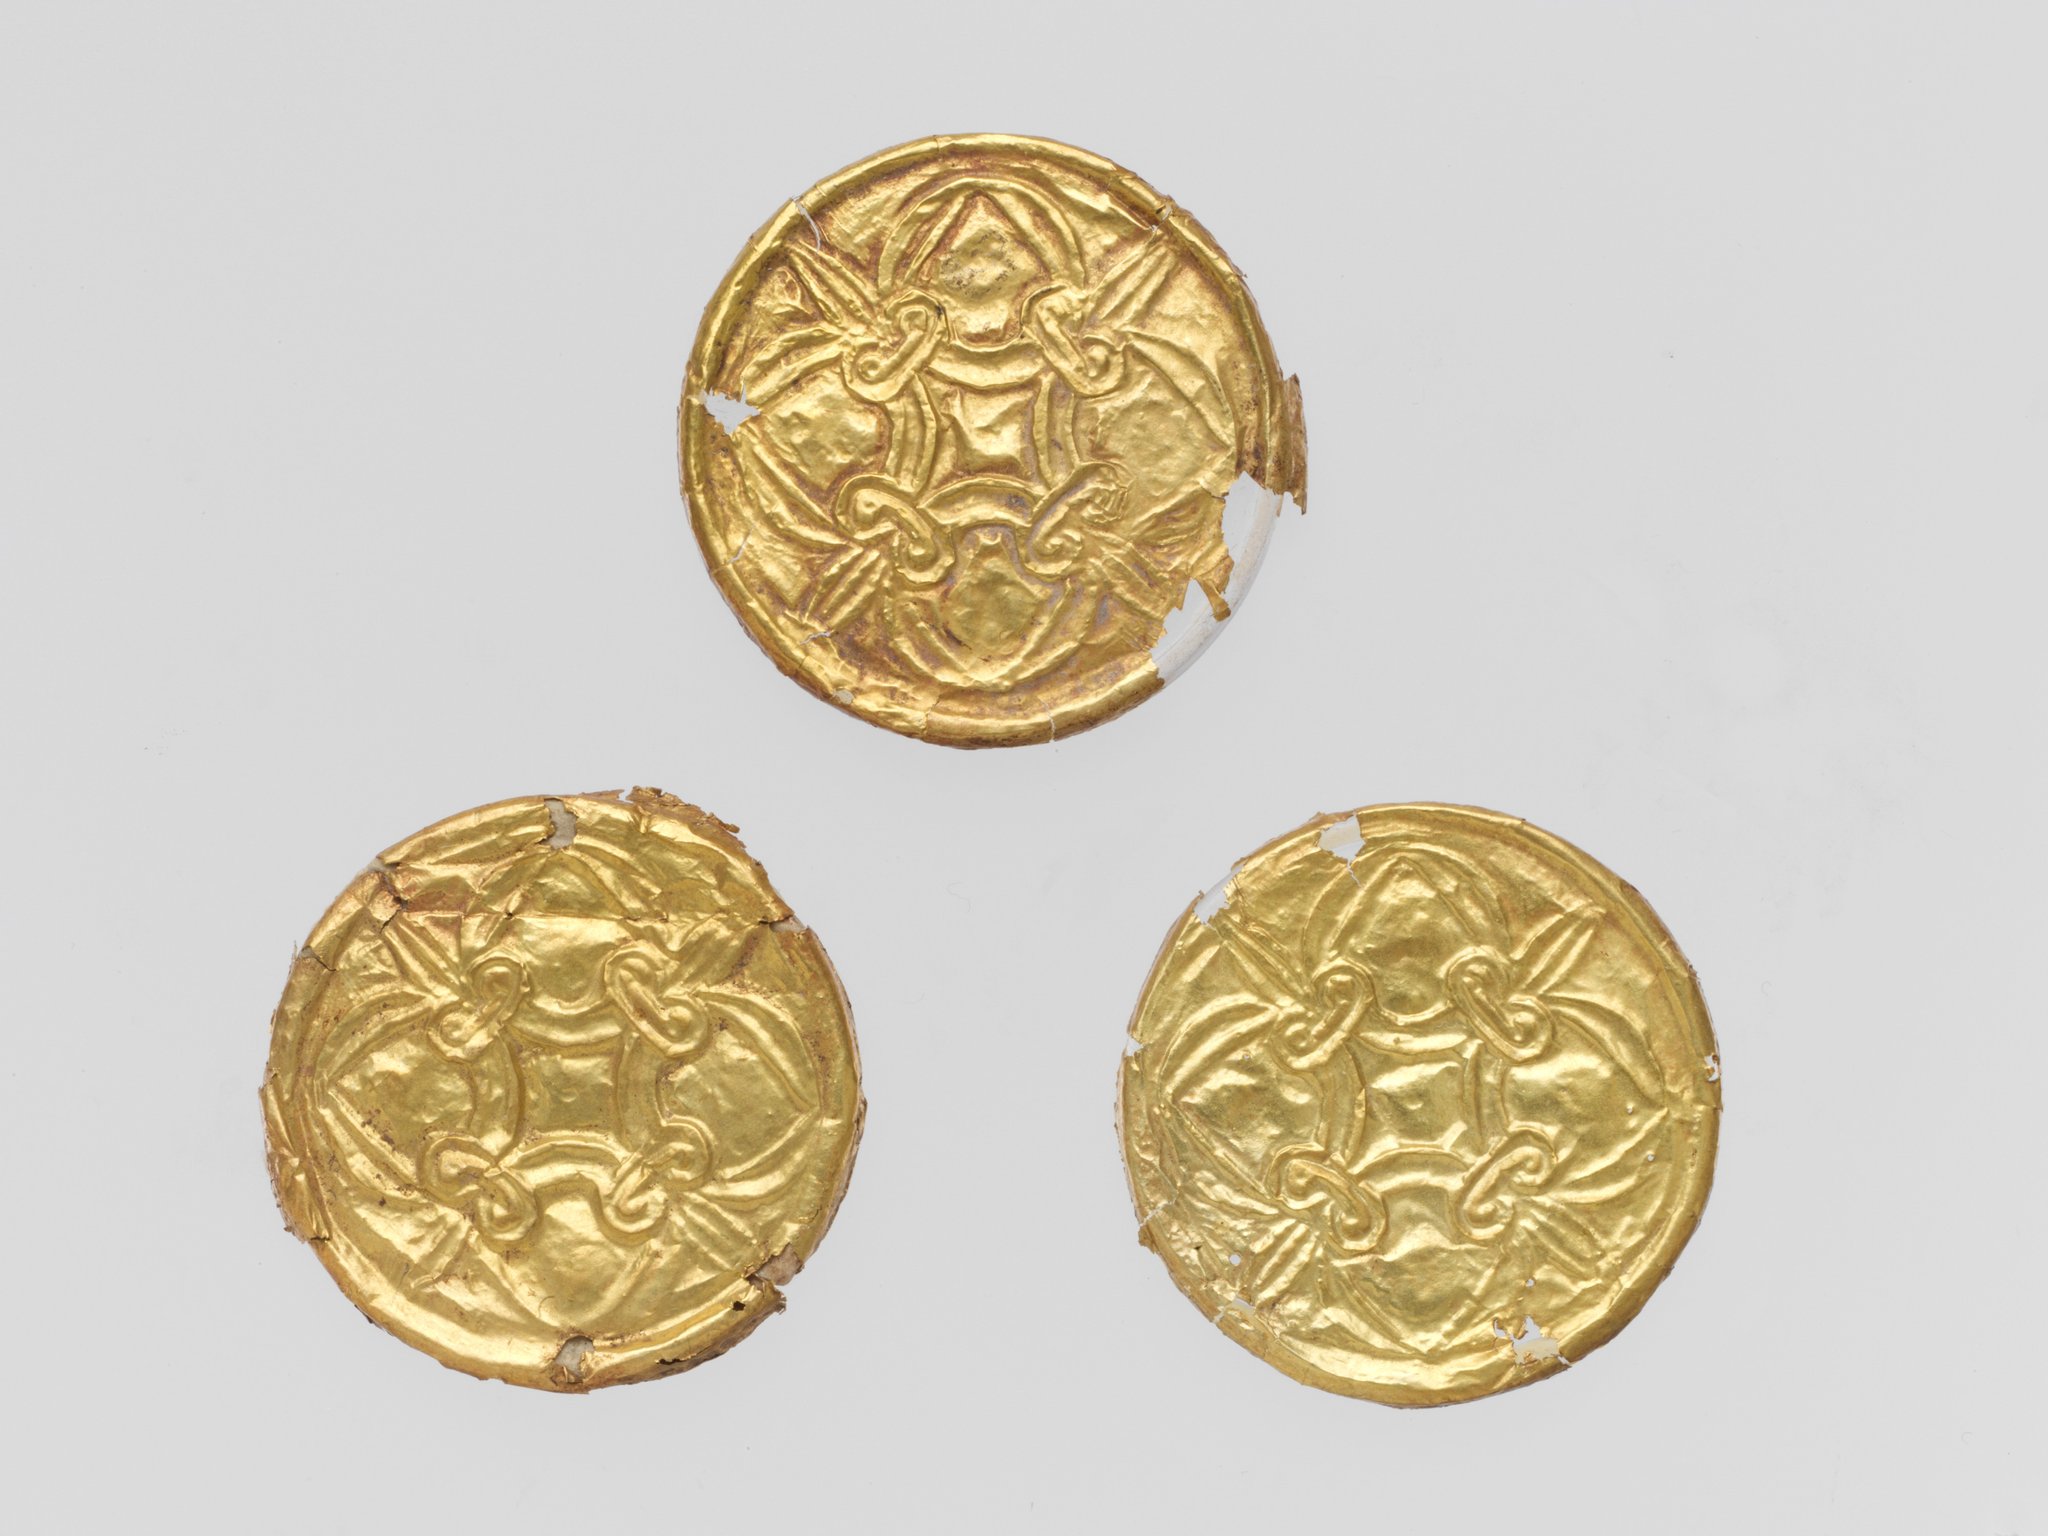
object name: roundel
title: Gold roundel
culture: cypriot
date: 1600-1050 BCE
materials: gold